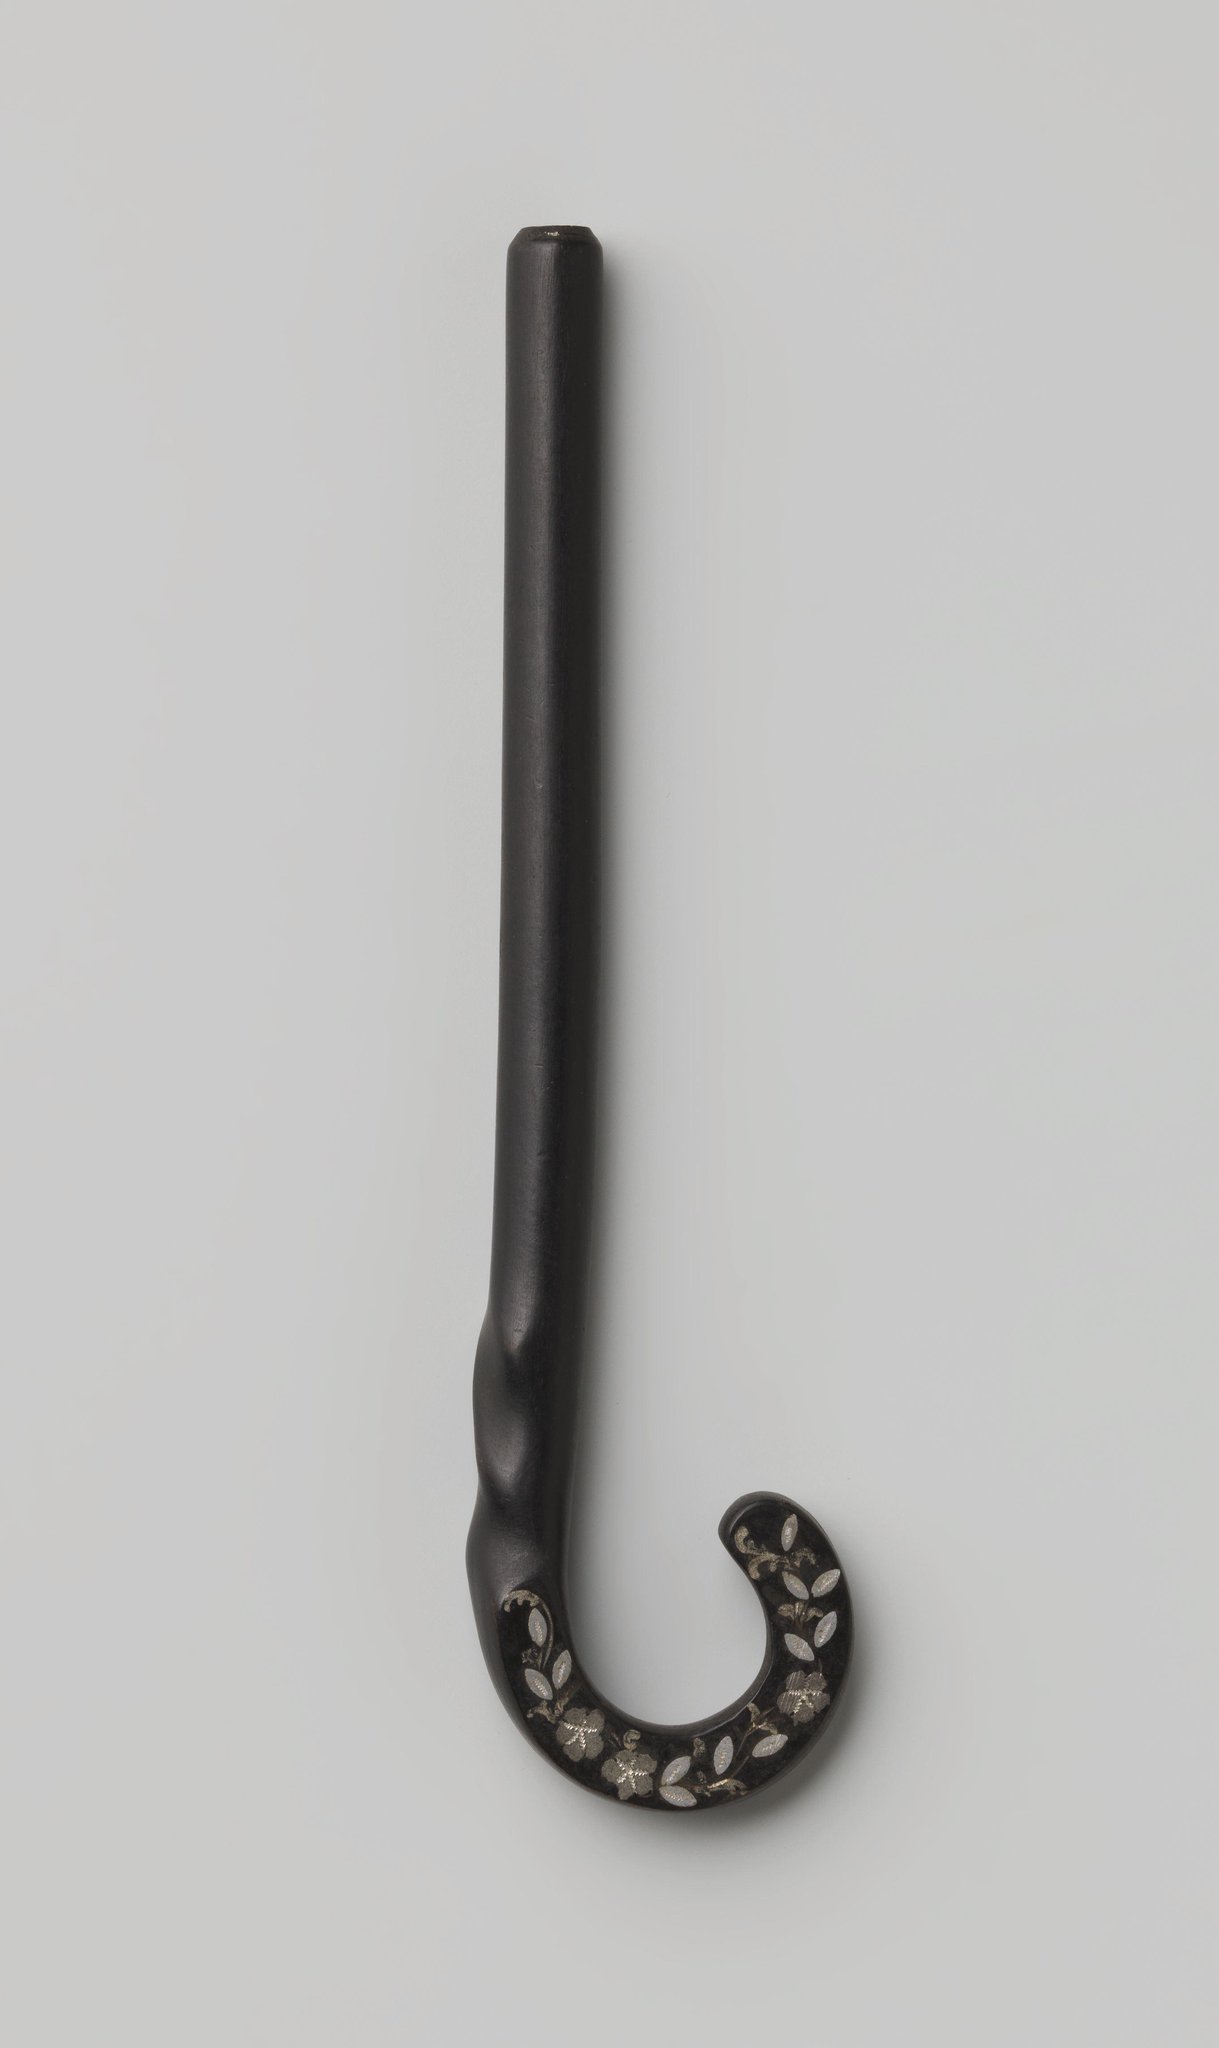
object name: handle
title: Handvat voor een paraplu of parasol van zwarte kunststof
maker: gustav schnitzler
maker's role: paraplufabrikant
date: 1910-1920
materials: plastic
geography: nijmegen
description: Ronde parapluie- en parasolknop. Klein, van zwart zilverkleurig inlegwerk van bloempjes, vogels en besjes.